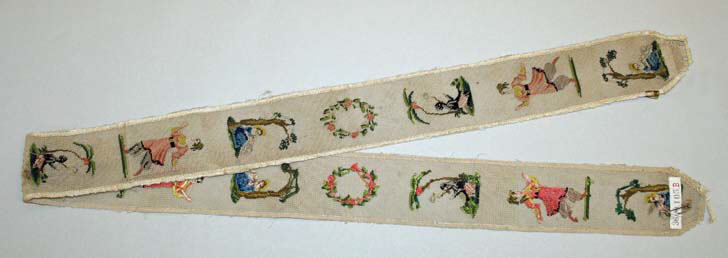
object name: suspender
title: Suspenders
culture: european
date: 1801-1900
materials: silk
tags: women,wreaths